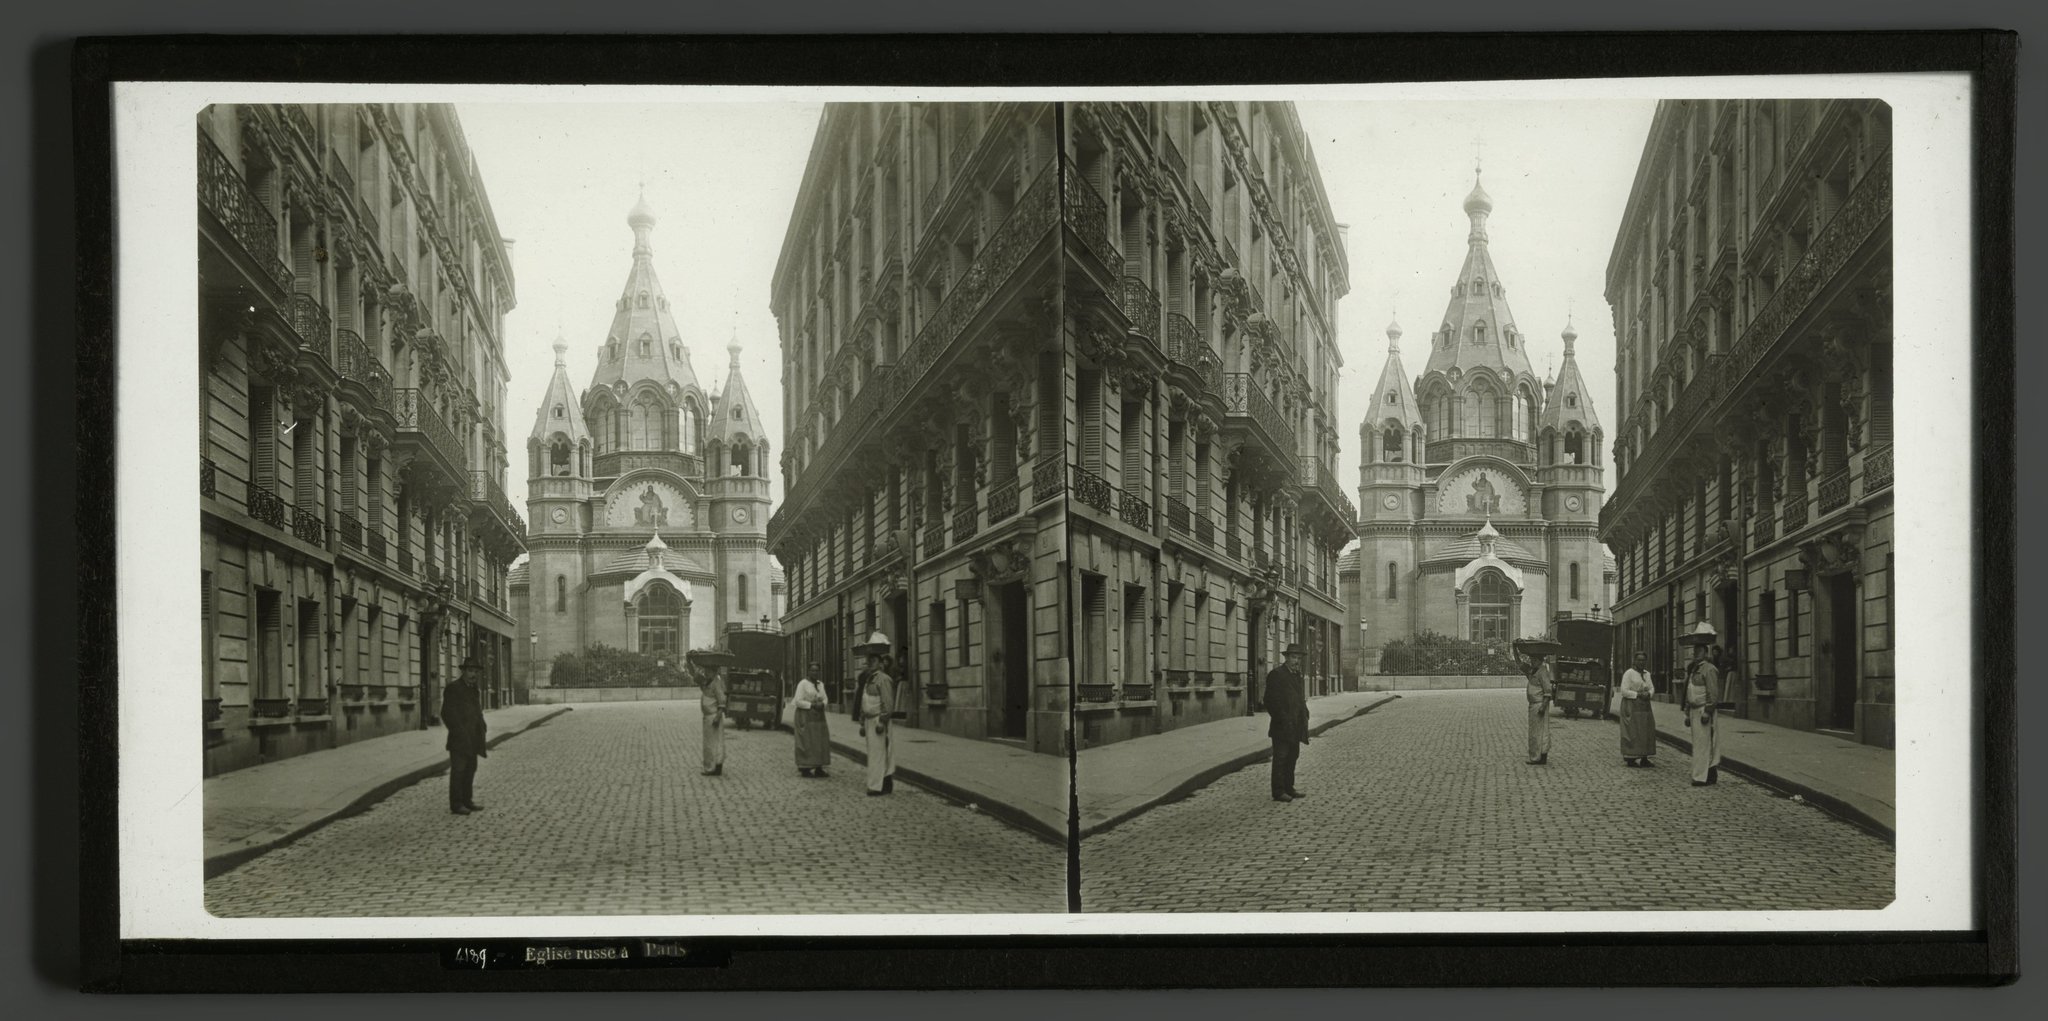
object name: stereoscopic photograph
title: Eglise russe a Paris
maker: Anonymous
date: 1856-1890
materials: glass, paper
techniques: slide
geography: paris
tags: church (exterior), street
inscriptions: number: ‘4189’